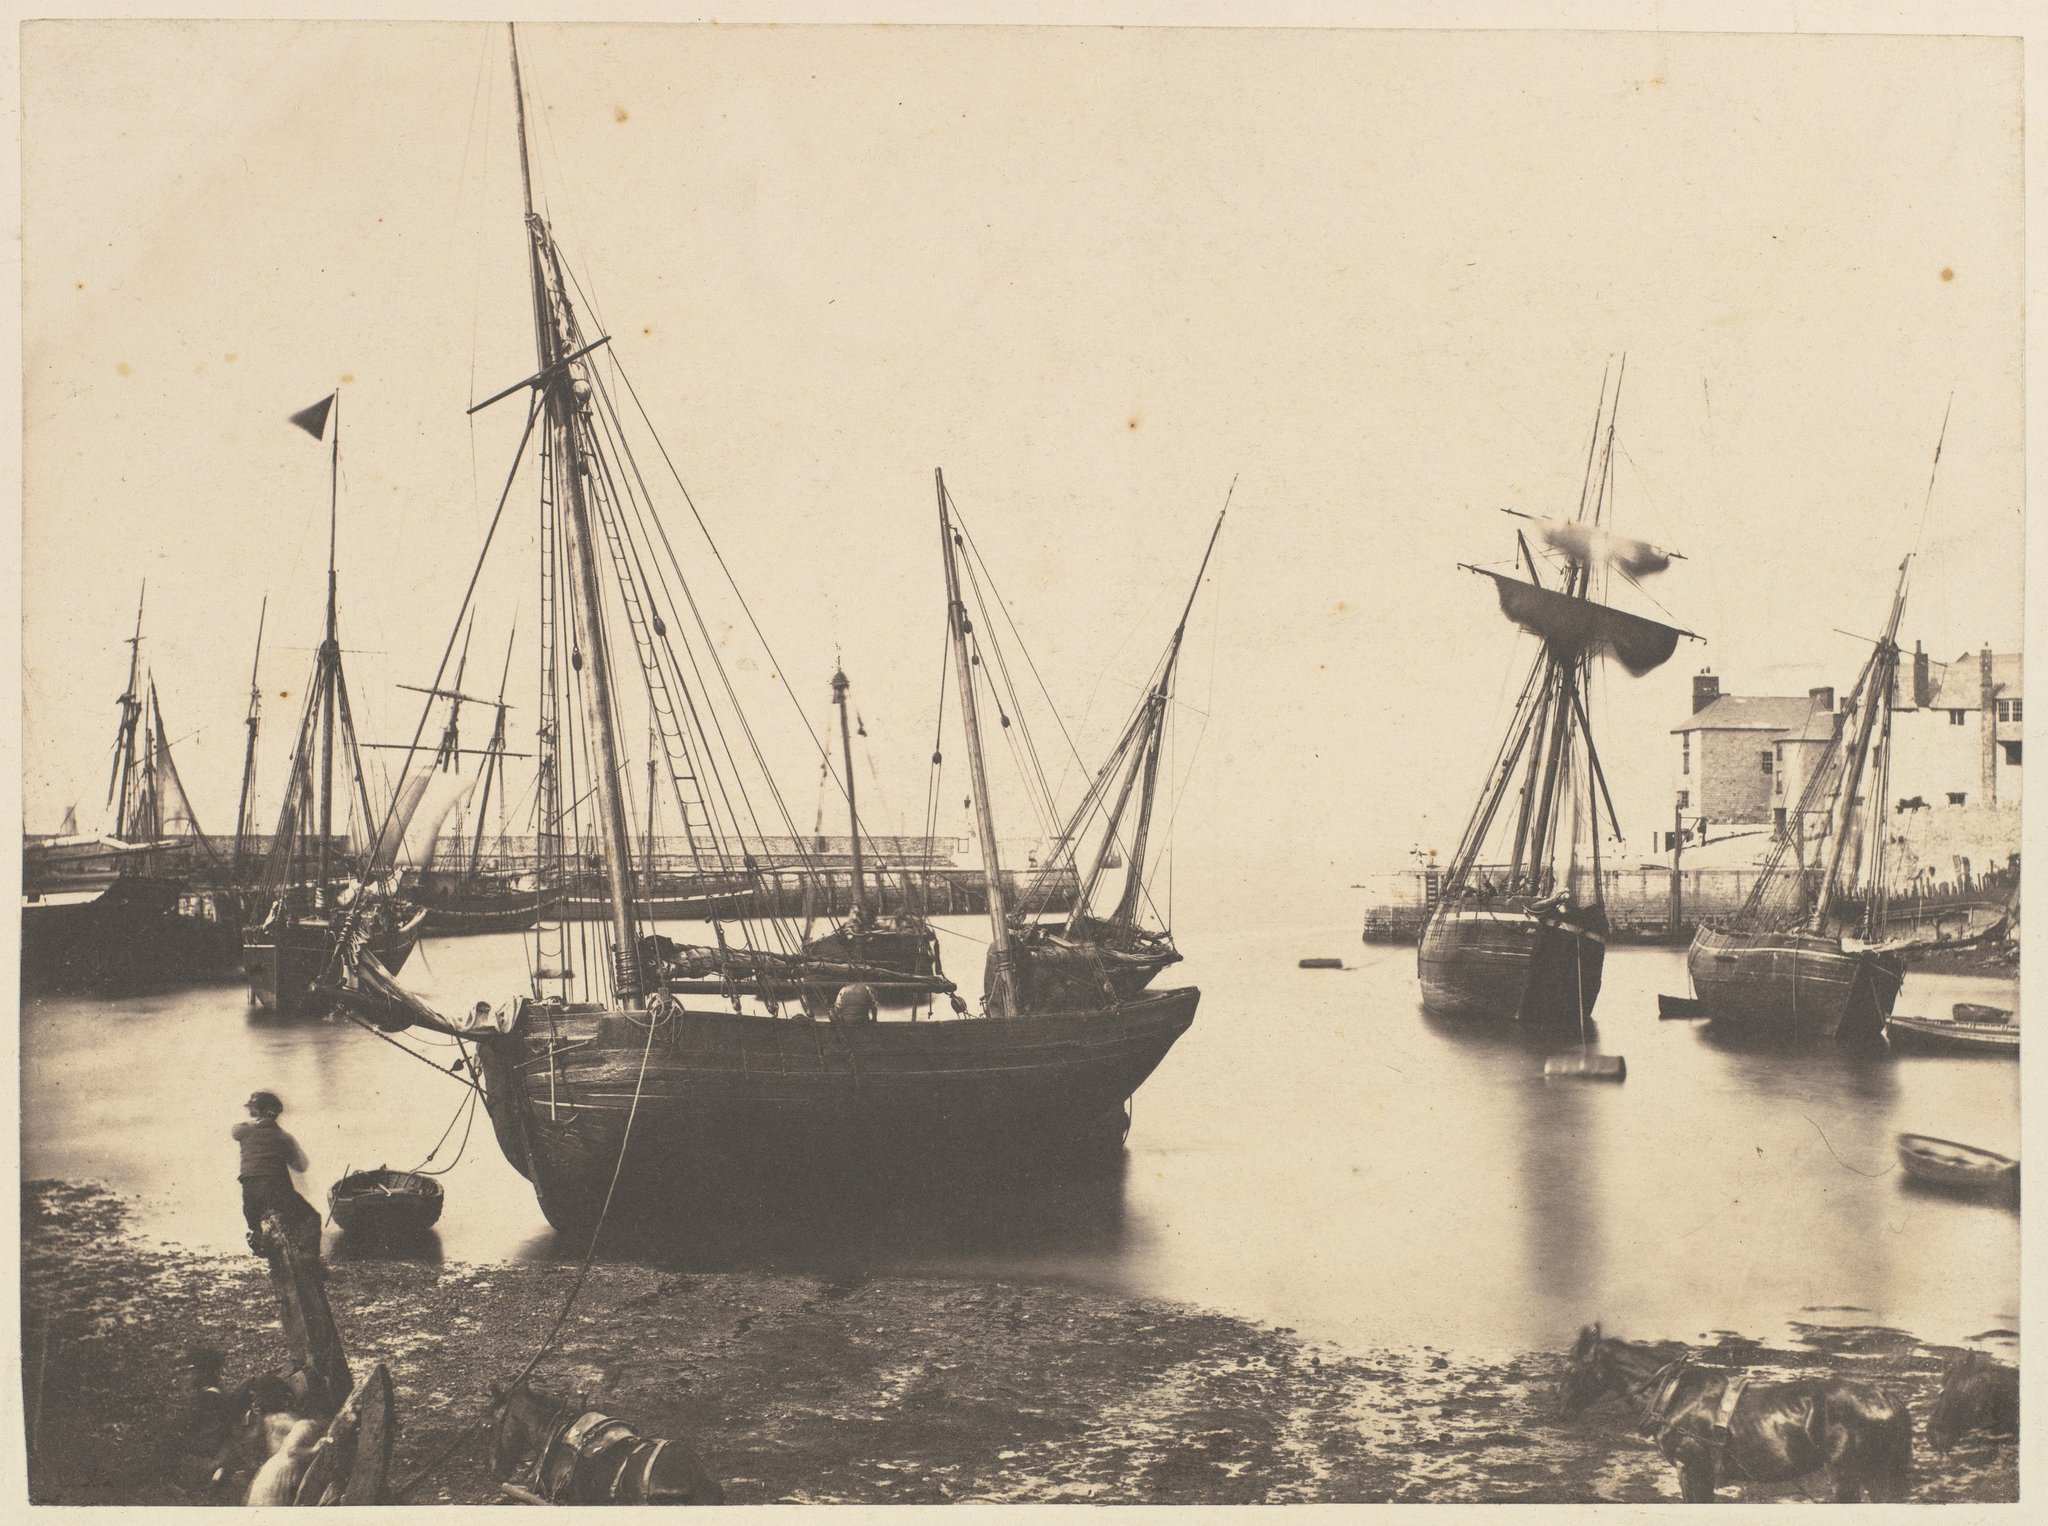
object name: photograph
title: Harbor Scene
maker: thomas sutton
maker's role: artist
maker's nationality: british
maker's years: 1819-1875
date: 1855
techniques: paper negative, salted paper print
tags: ships,harbors